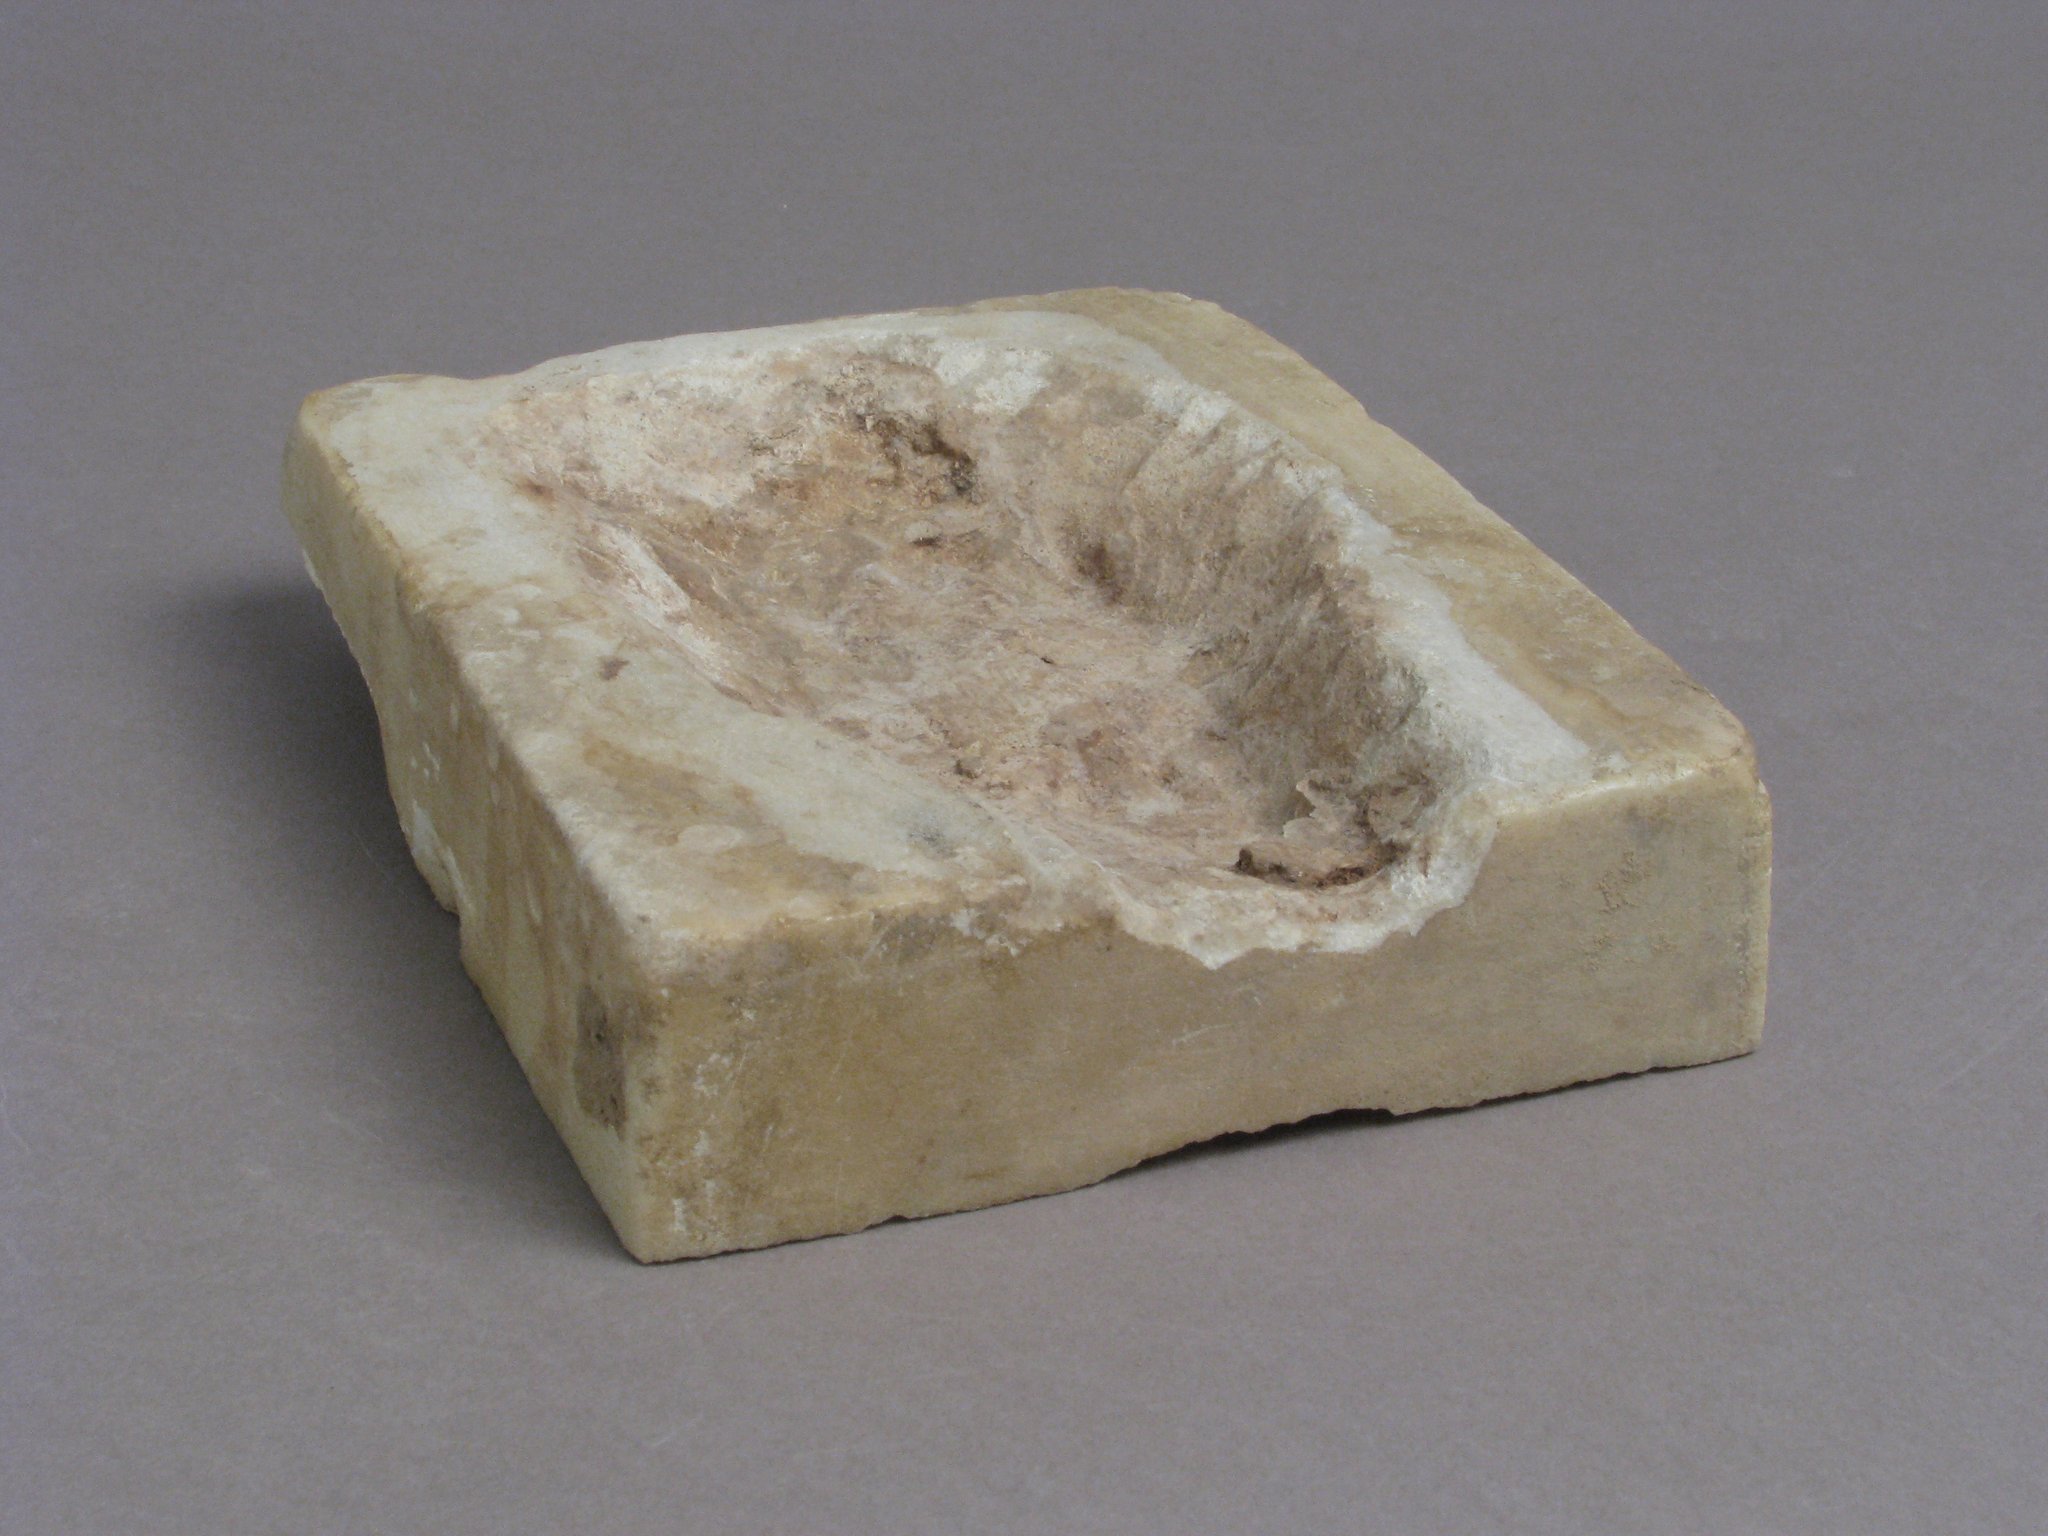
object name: mold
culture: coptic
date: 301-700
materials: marble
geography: egypt